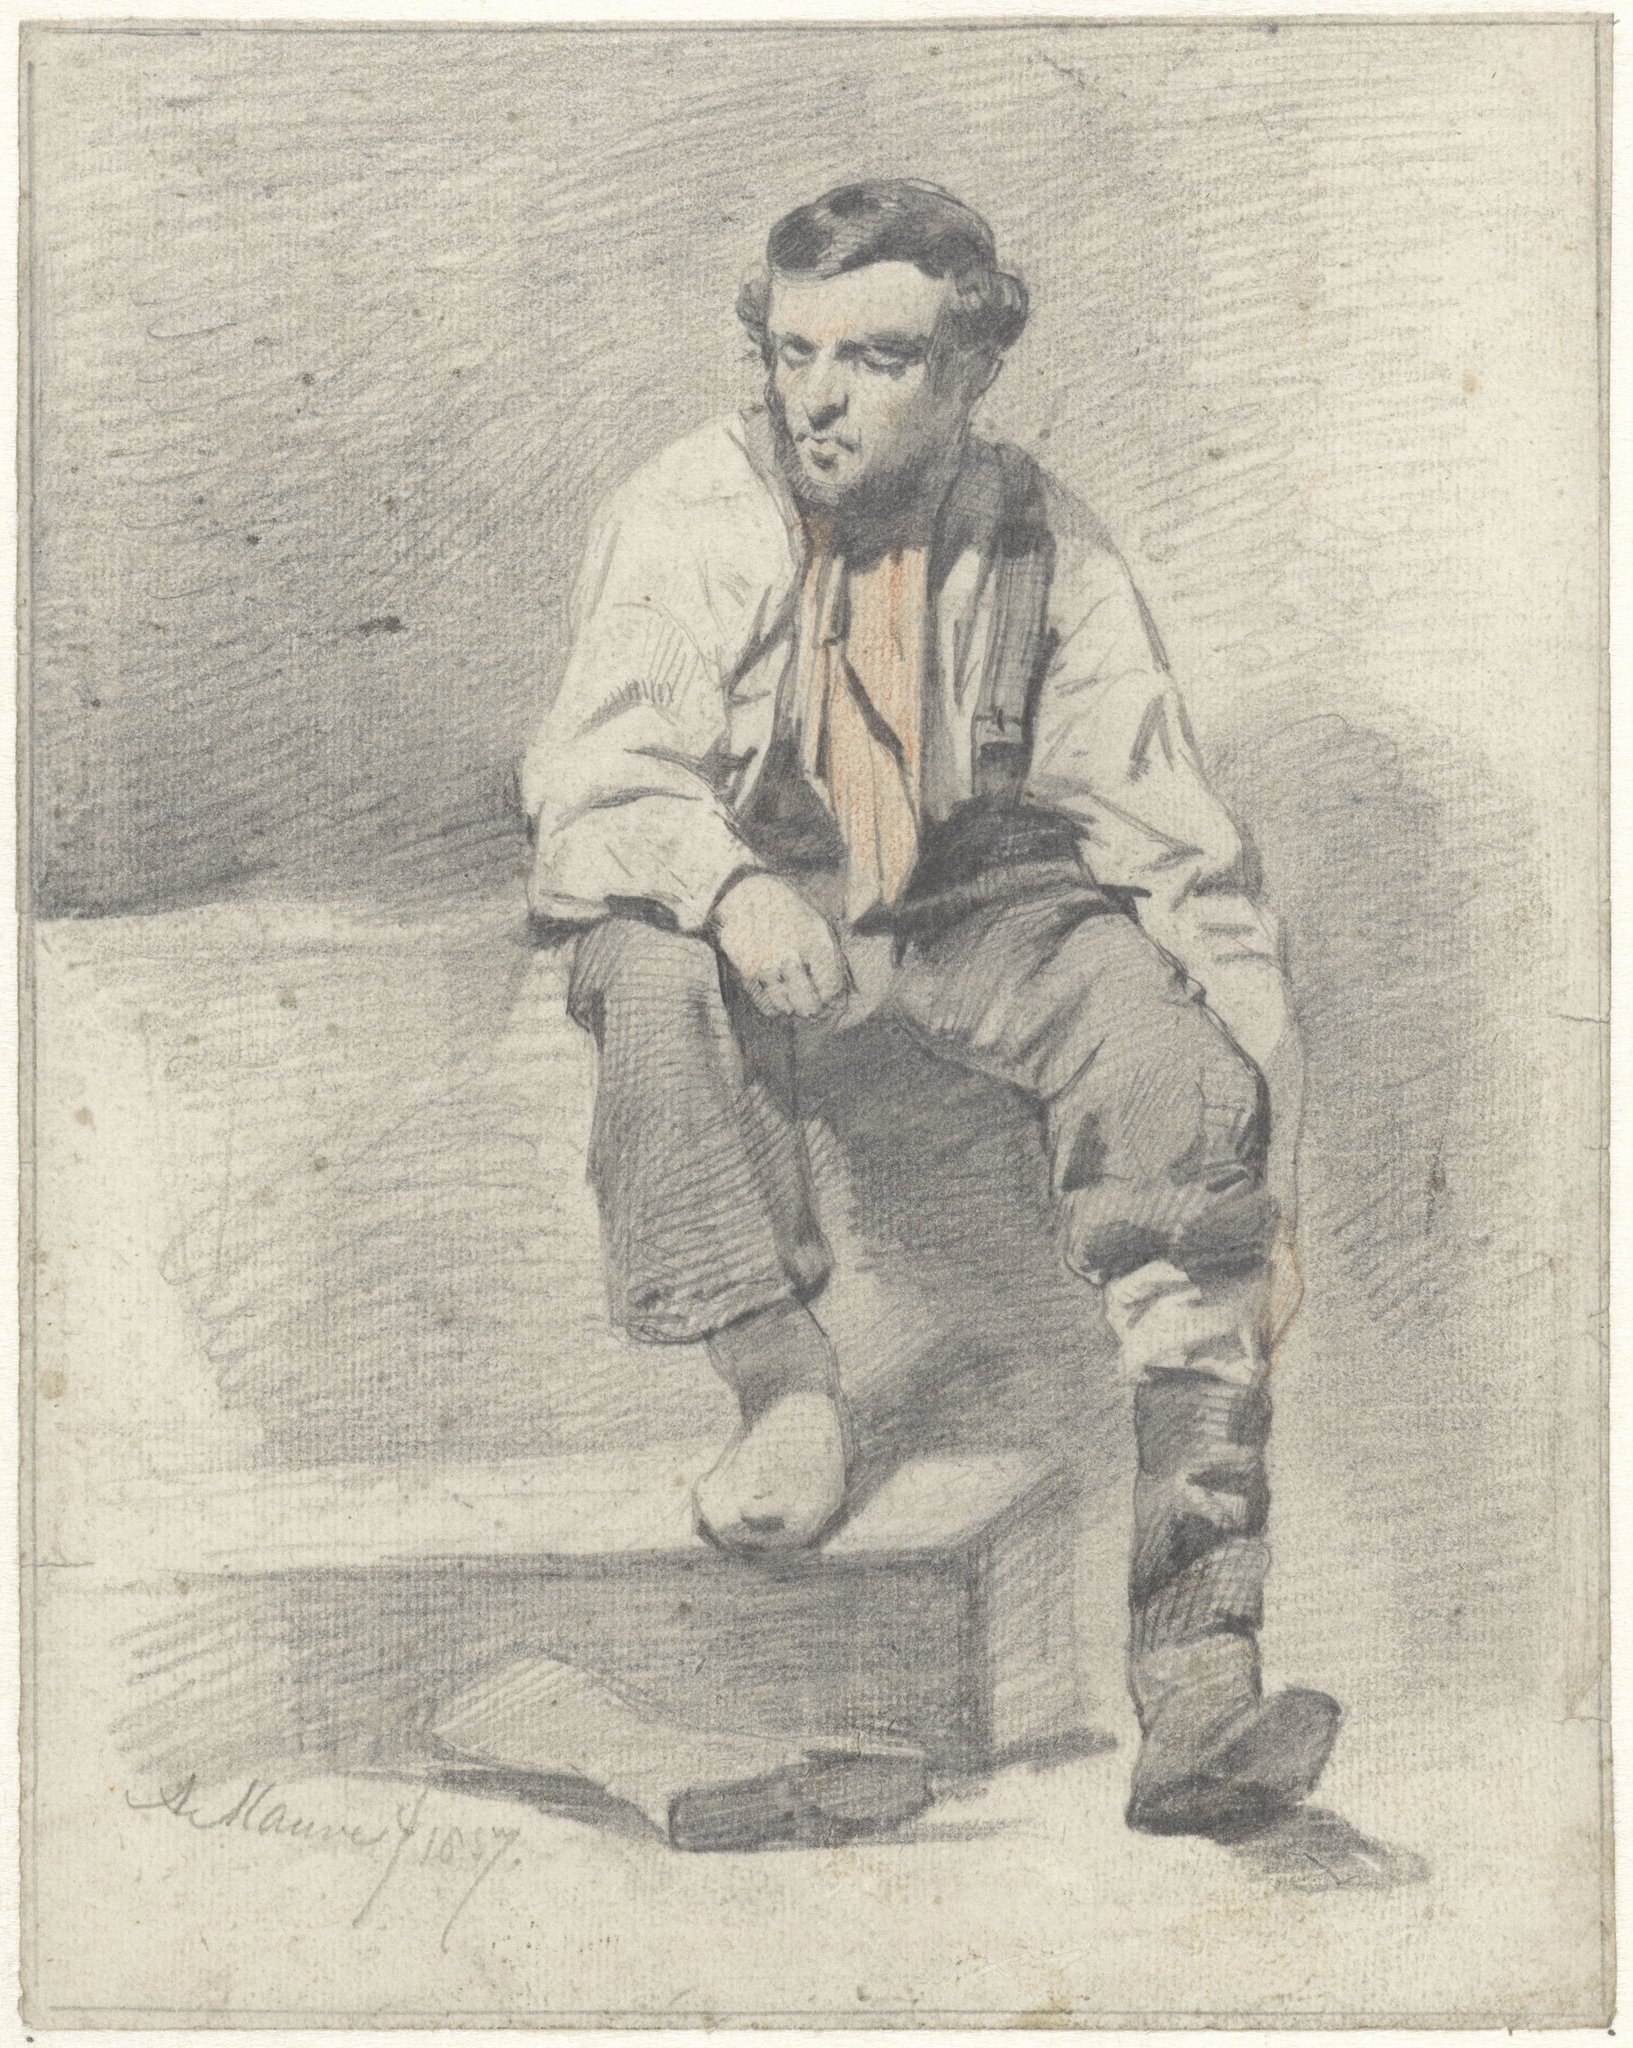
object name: drawing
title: Zittende werkman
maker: anton mauve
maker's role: draughtsman, painter, print maker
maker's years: 1838-1888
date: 1857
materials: chalk, paper, pencil